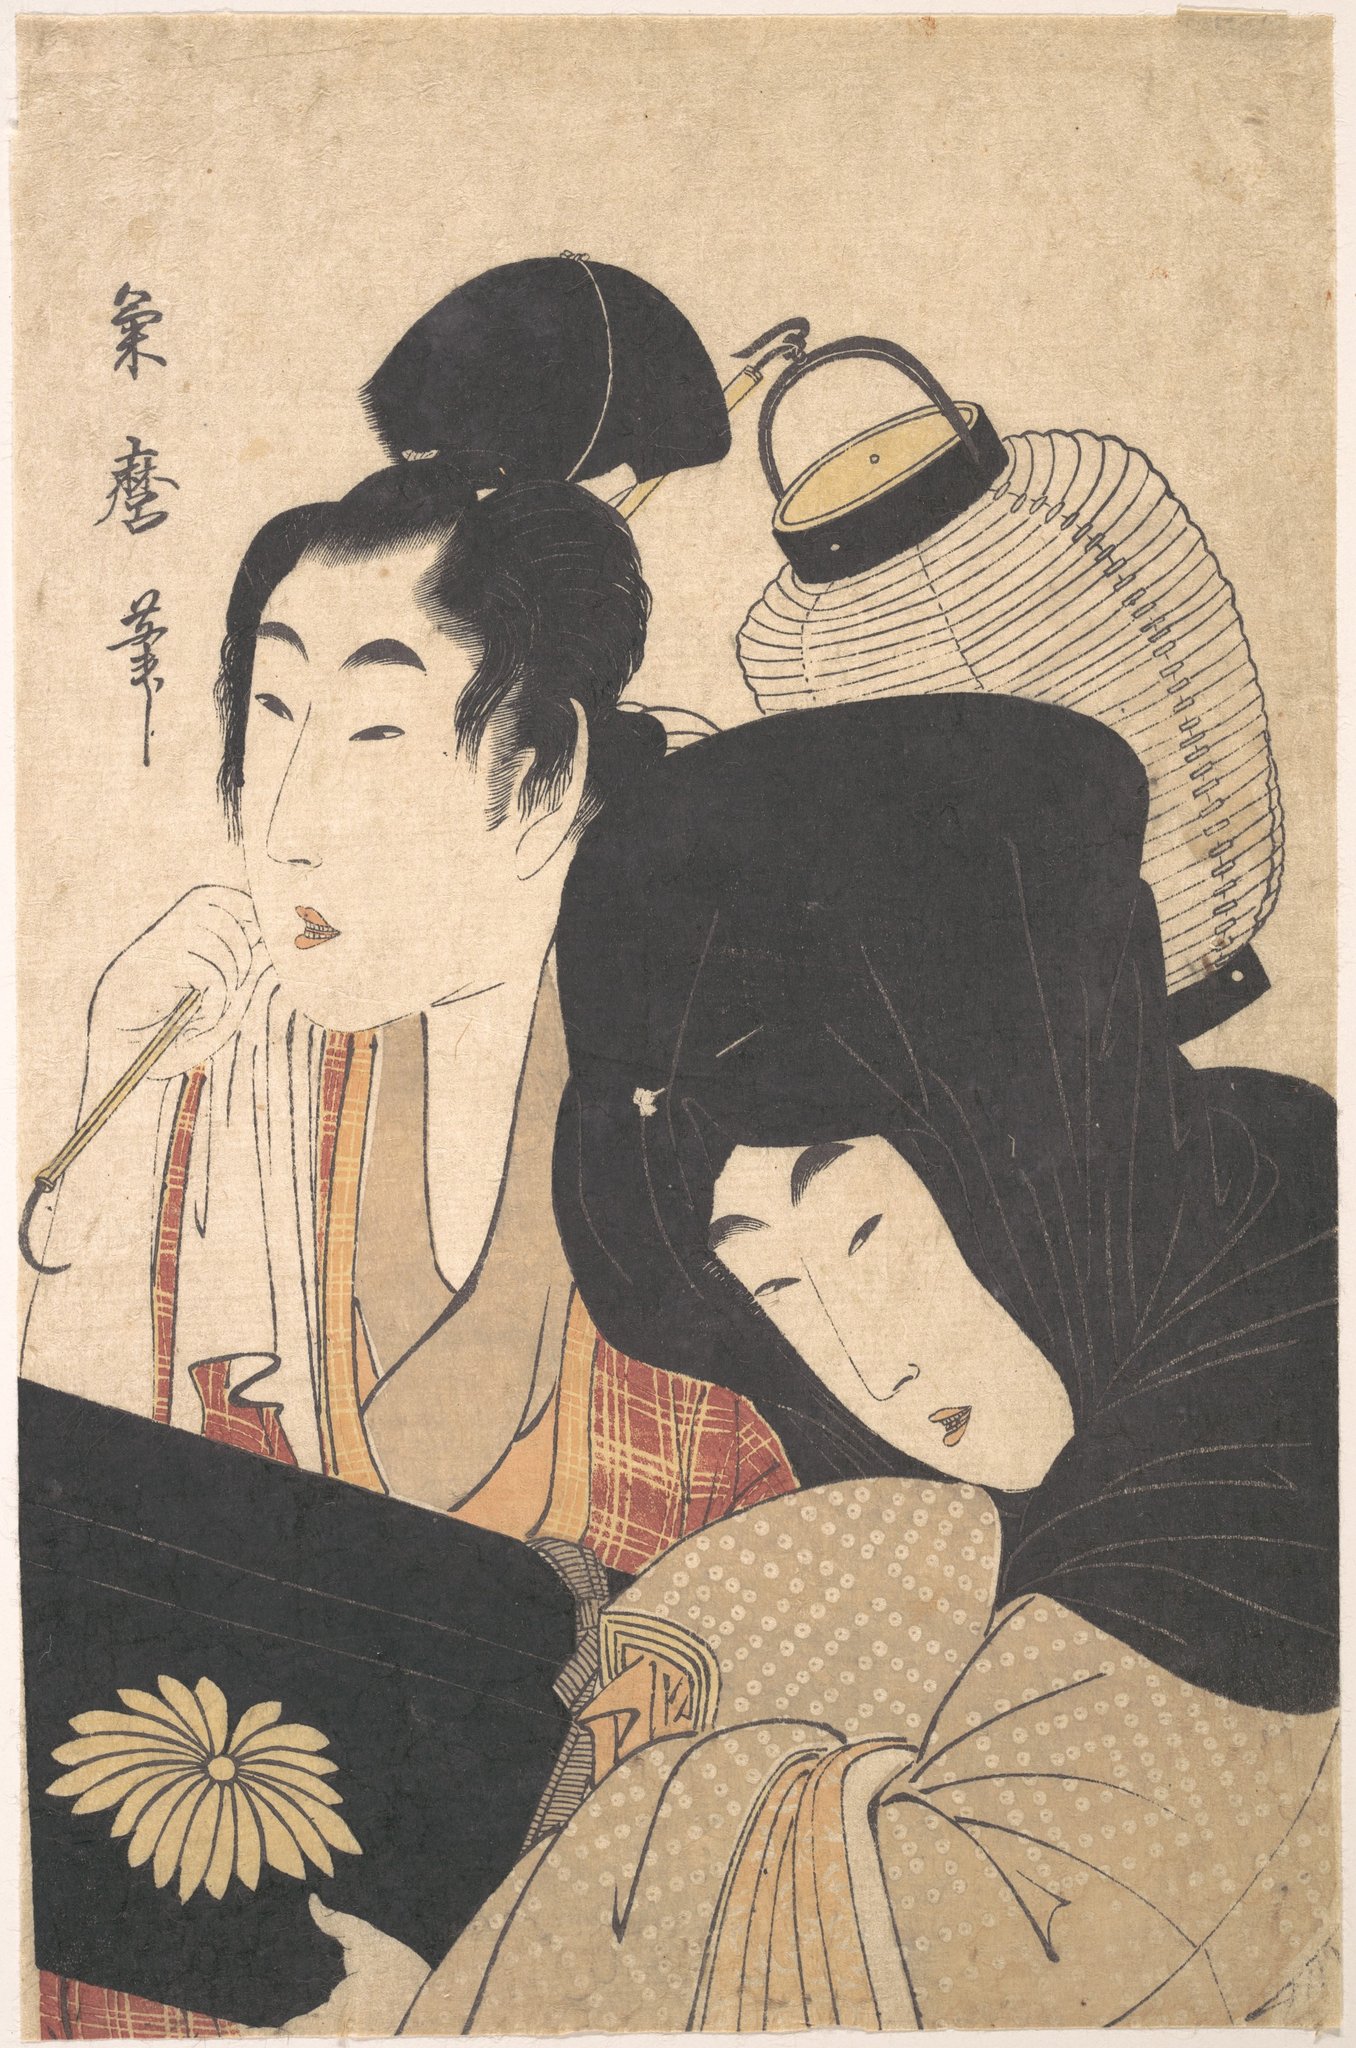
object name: woodblock print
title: Young Woman at Night accompanied by a Servant Carrying a Lantern and a Shamisen Box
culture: japanese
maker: kitagawa kikumaro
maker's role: artist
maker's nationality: japanese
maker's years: -1830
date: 1789-1829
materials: ink, paper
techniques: woodblock print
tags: women,lanterns